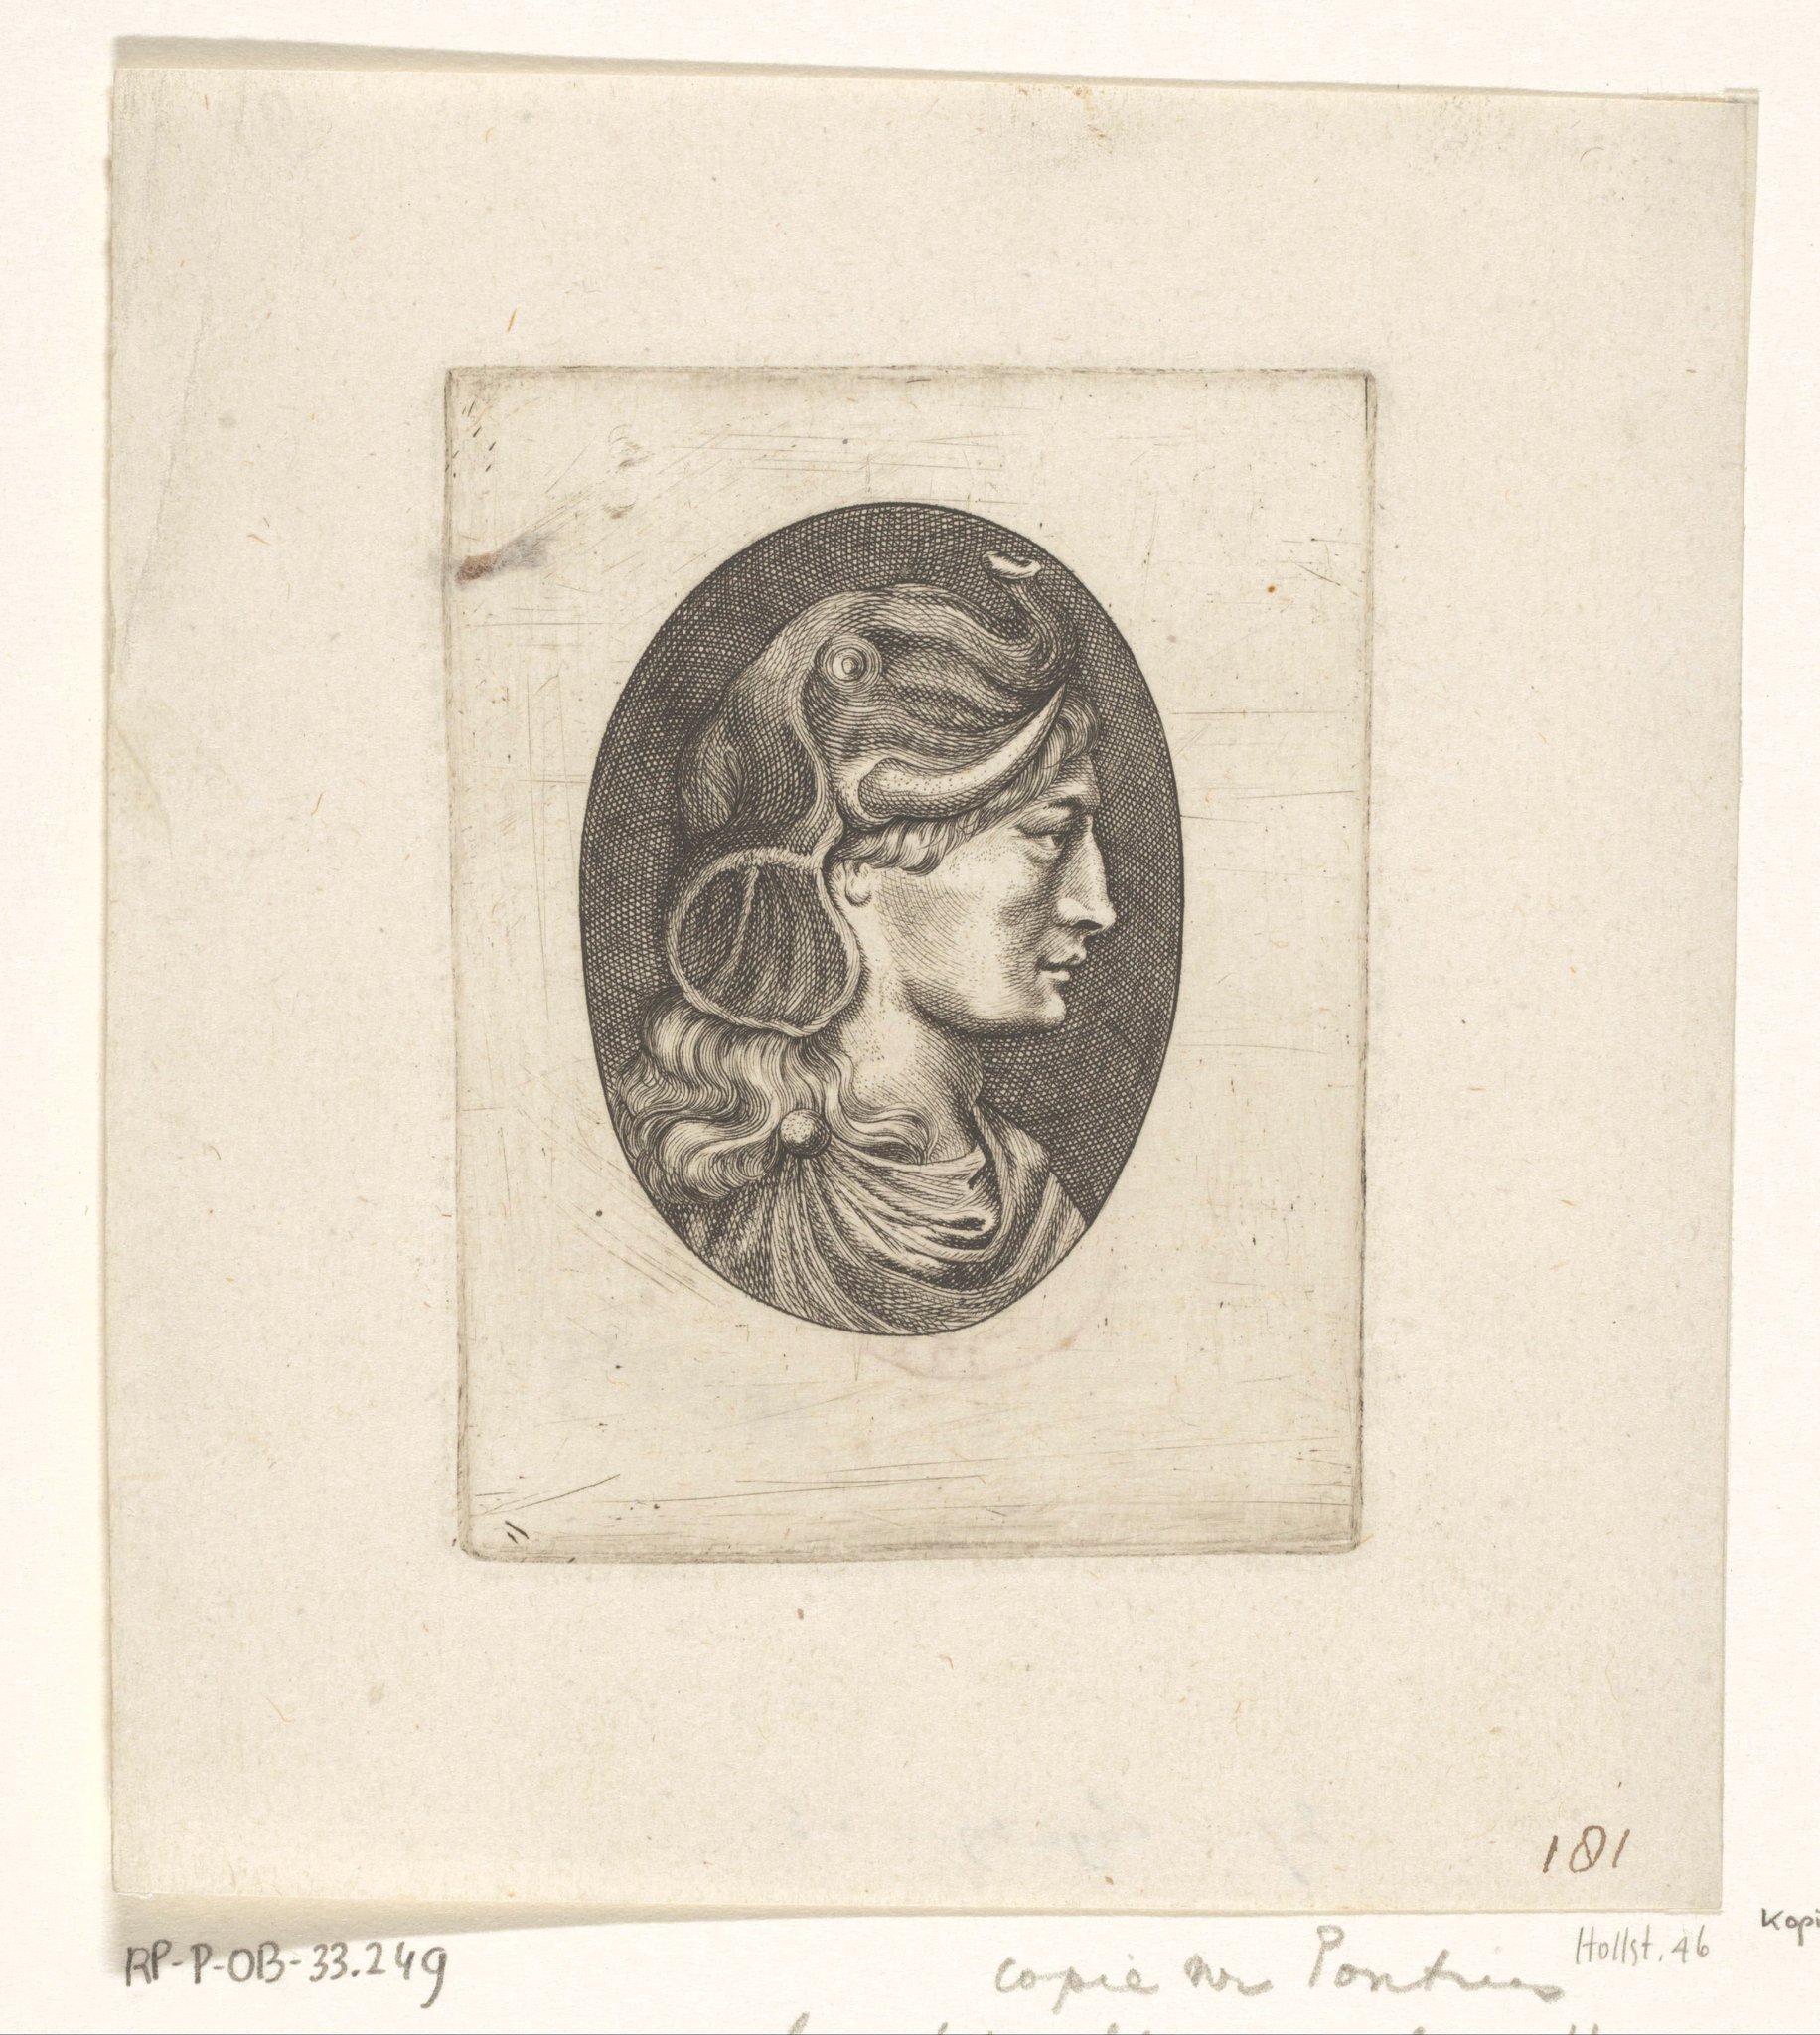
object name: print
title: Camee met de personificatie van Afrika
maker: Anonymous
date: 1616-1707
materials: paper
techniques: engraving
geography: antwerp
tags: africa represented allegorically; 'africa' (ripa), brooch, agraffe, clasp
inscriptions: number: ‘181’, collector's mark: Lugt 240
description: De camee bevindt zich in de collectie van het Cabinet des Médailles te Parijs.